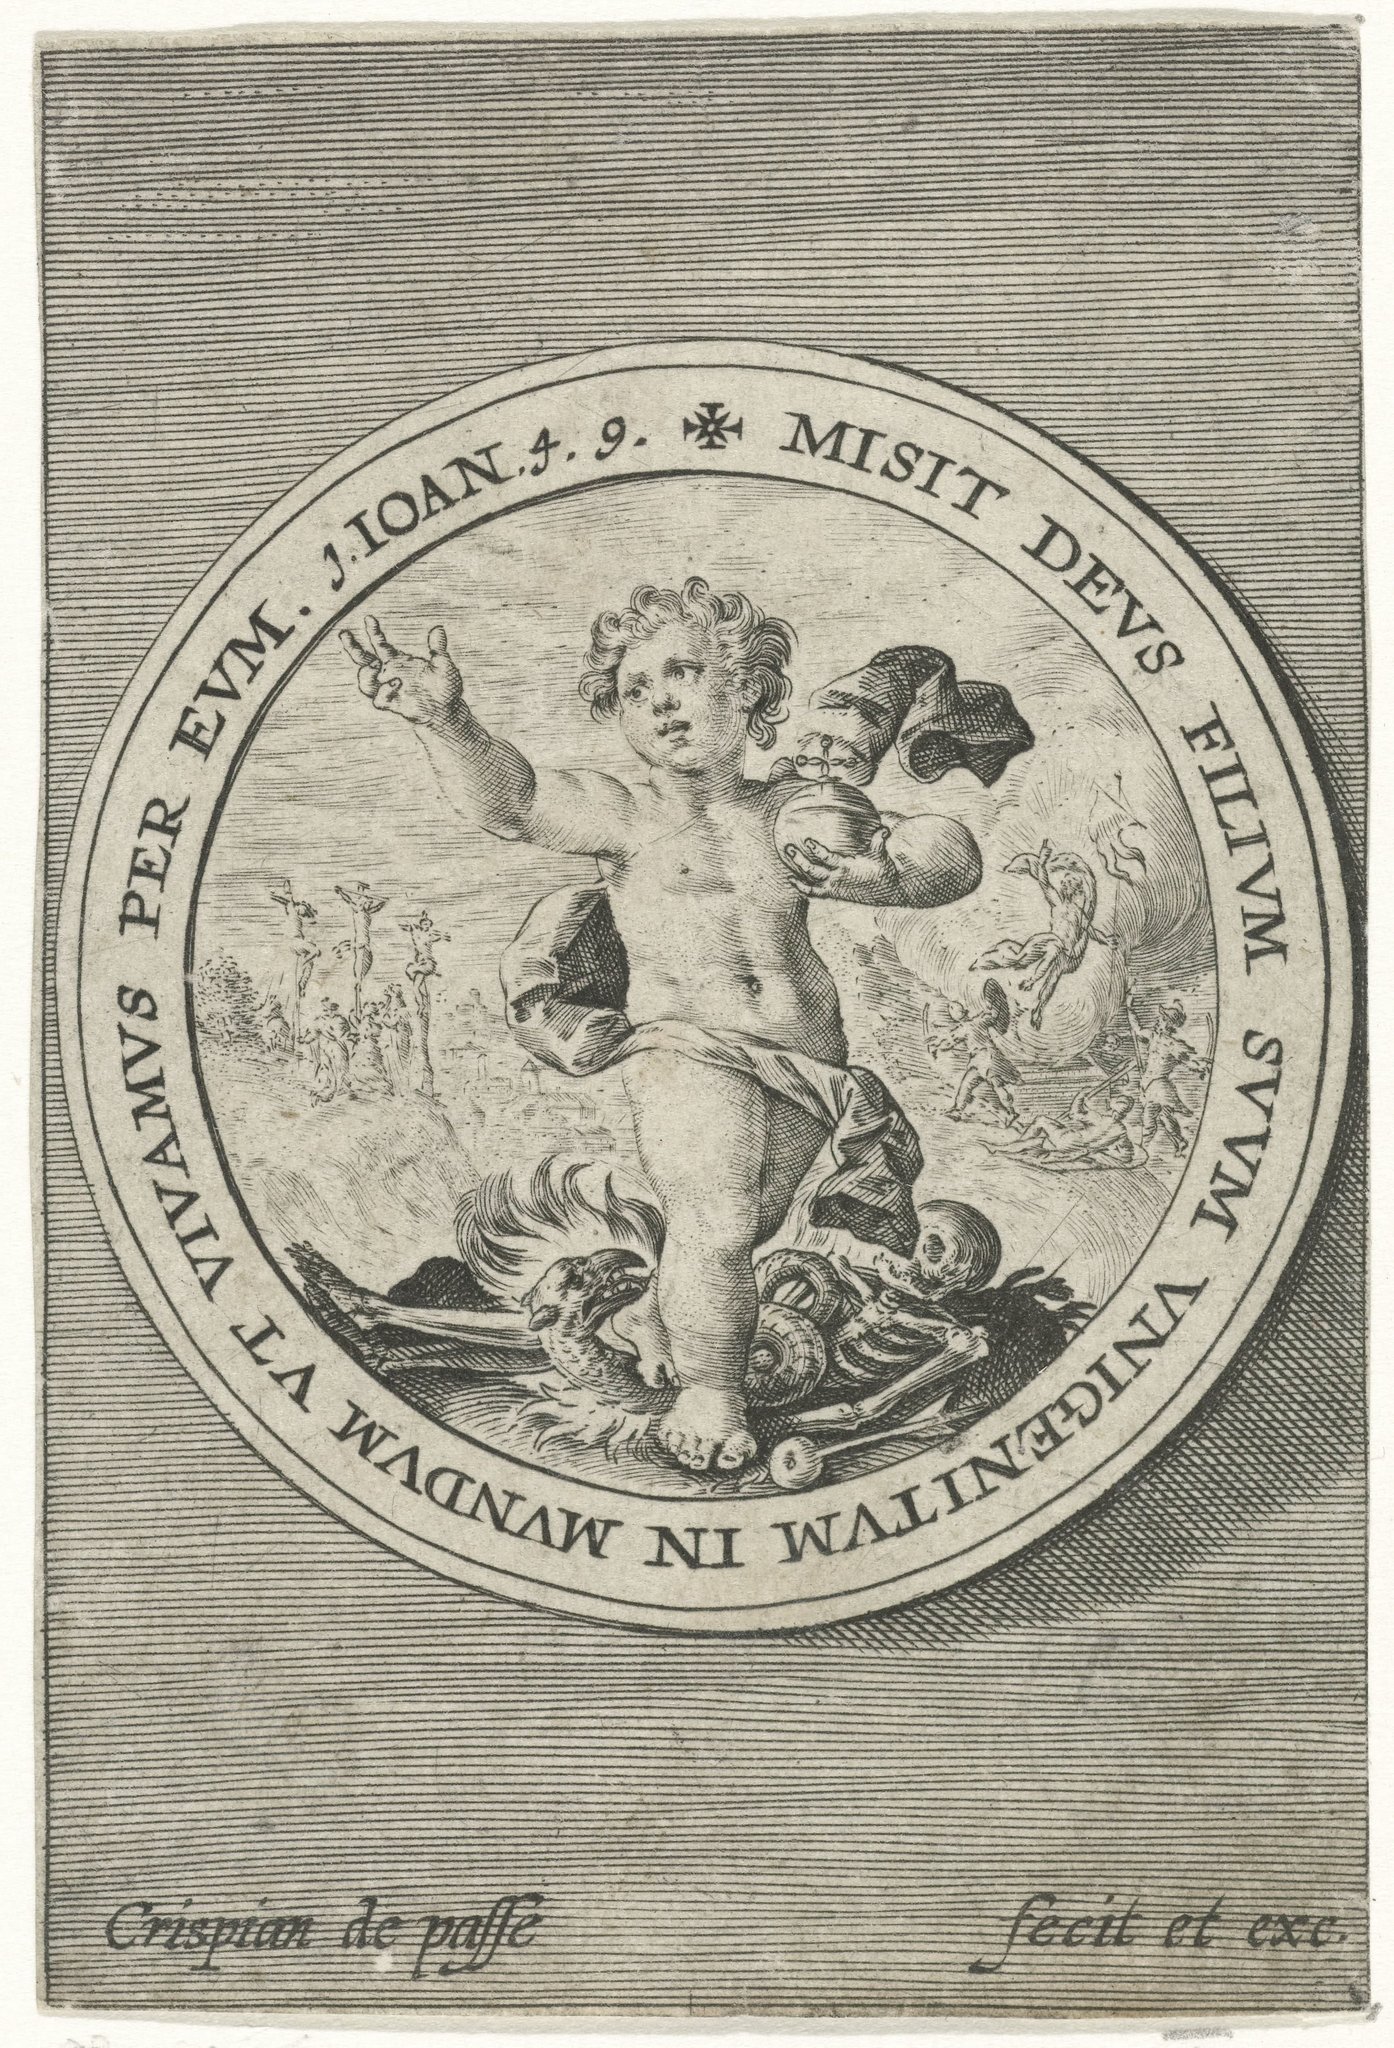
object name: print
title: Putti die Gods woord verbeelden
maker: crispijn van de passe (i)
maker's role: draughtsman, print maker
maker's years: 1564-1637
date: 1594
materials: paper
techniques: engraving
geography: cologne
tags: christ, usually holding a banner, arises from the grave; often combined with sleeping and/or frightened soldiers - ee - the tomb closed (with unbroken seals), 'salvator mundi', making a blessing gesture; an orb in his hand or at his feet (+ devil(s)), crucified christ with mary, john, and mary magdalene, angel(s) represented as child(ren)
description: Medaillon met putto als Salvator Mundi die een duivel en de Dood vertrapt. Op de achtergrond de kruisiging en de opstanding van Christus. De prent heeft een omlijsting met een Bijbelcitaat uit Joh. 4:9 in het Latijn.